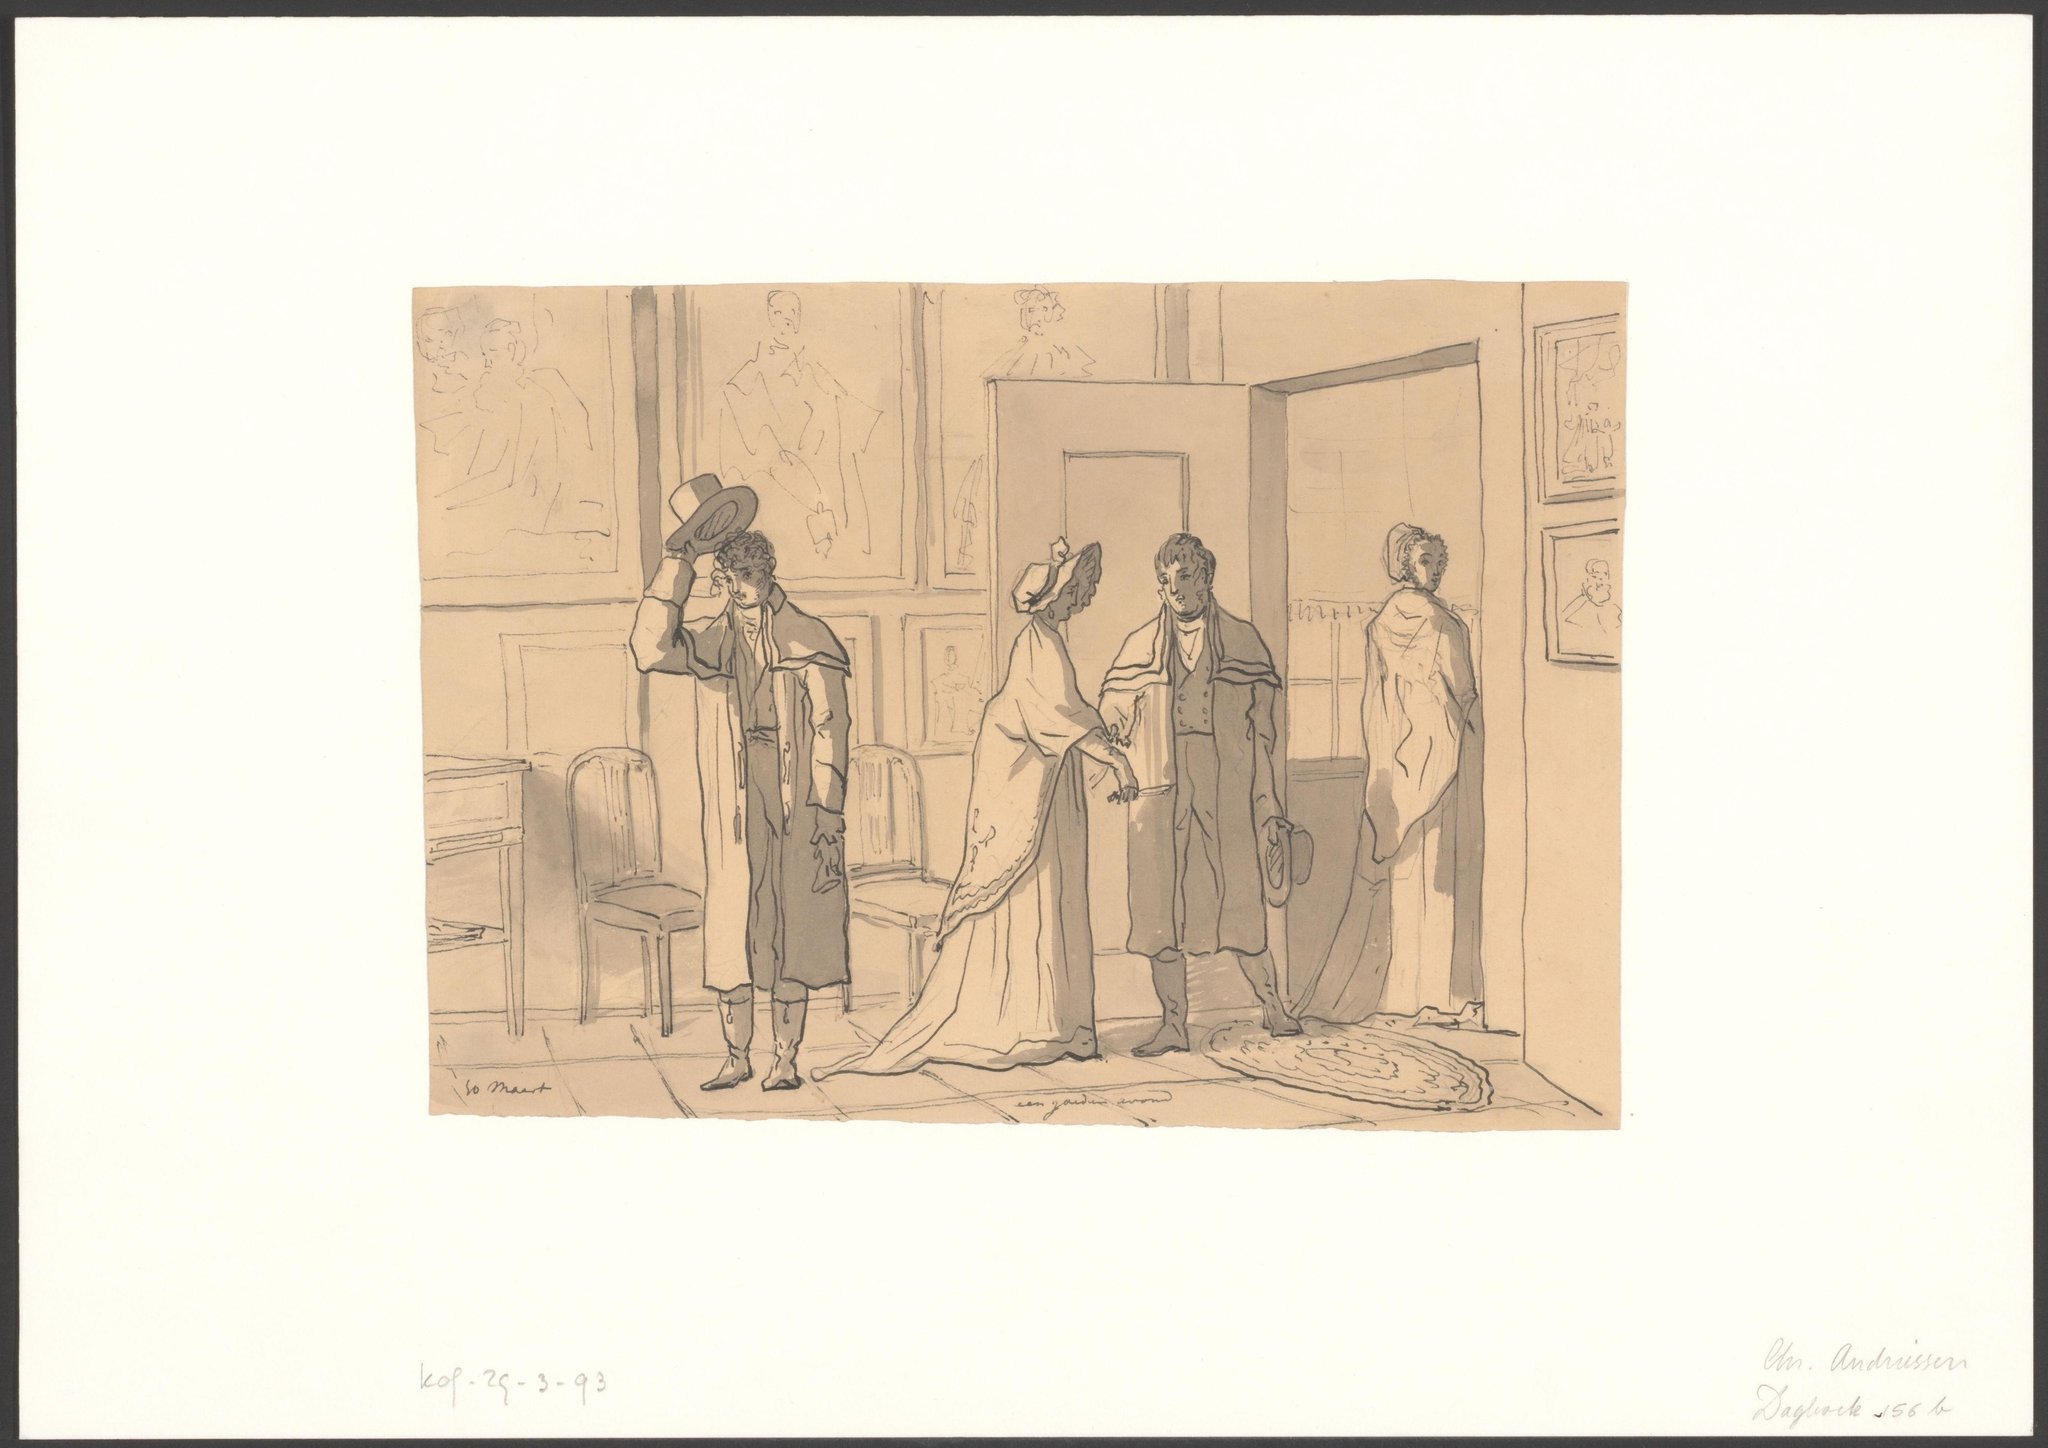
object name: drawing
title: Christiaan Andriessen neemt afscheid na een leuke avond op het Zonshofje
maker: christiaan andriessen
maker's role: draughtsman, print maker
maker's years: 1775-1846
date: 1805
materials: ink, paper, pencil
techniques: brush, pen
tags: amsterdam, print maker, draughtsman, christiaan andriessen, open door, picture, painting, parting, leave-taking (of lovers), head-gear: top hat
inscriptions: signature: ‘J Andriessen’, inscription: ‘10 maart een goeden avond’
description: Dagboekblad uit het getekende dagboek dat Christiaan Andriessen bijhield van 1805 tot en met 1808.